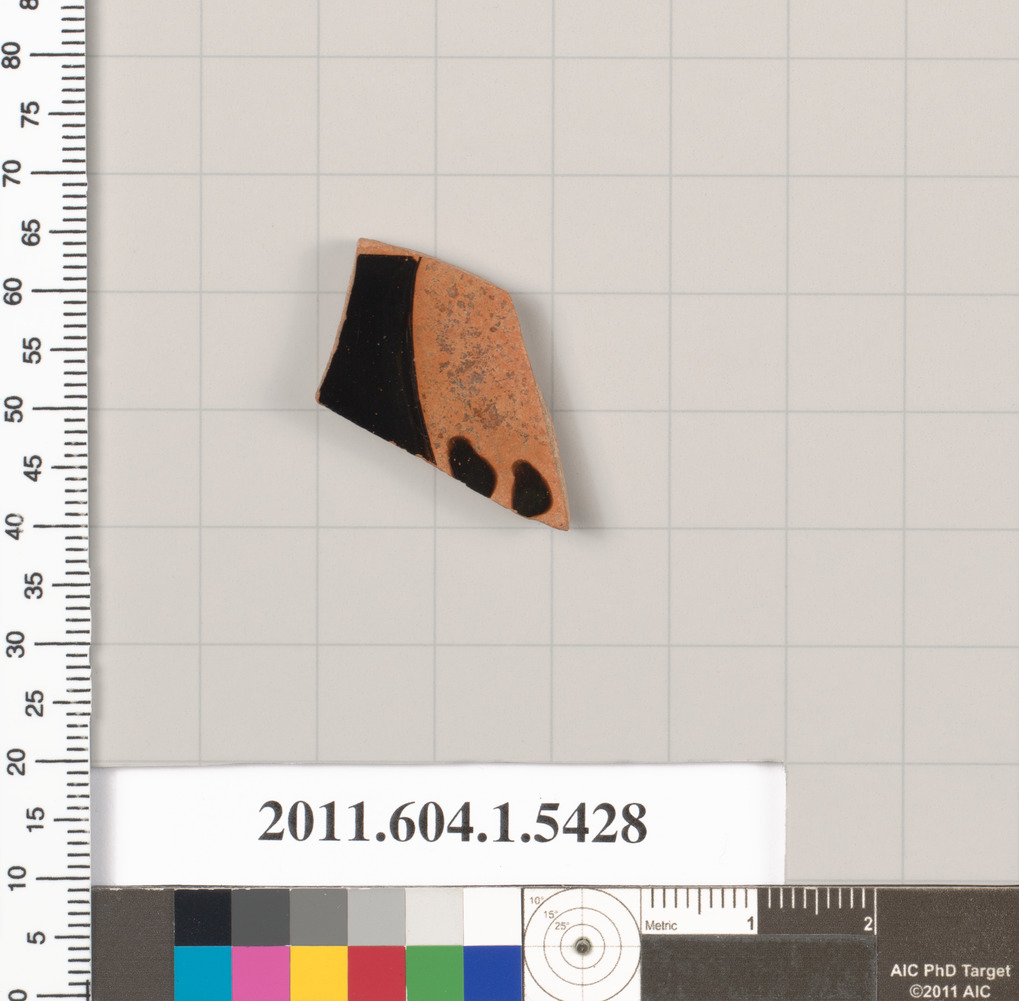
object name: kylix fragment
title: Terracotta fragment of a kylix (drinking cup)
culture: greek, attic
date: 500-480 BCE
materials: terracotta